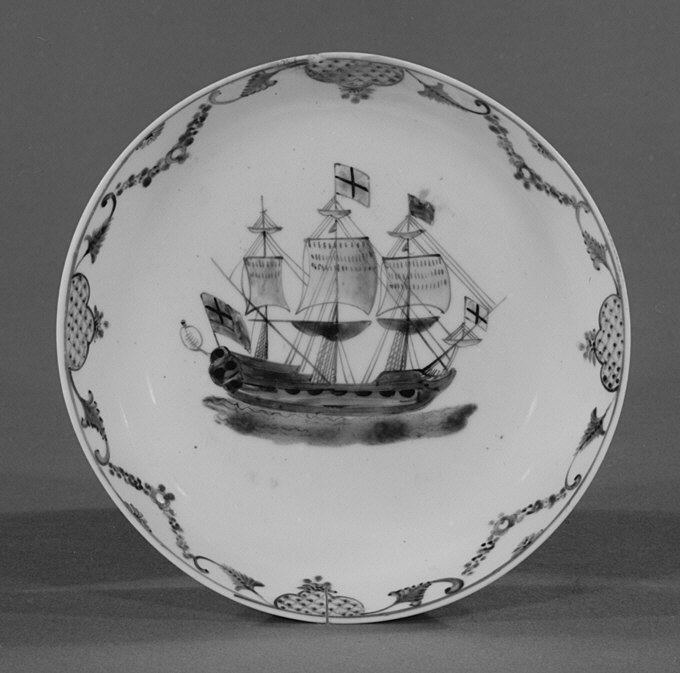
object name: saucer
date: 1780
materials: hard paste porcelain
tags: flags,ships